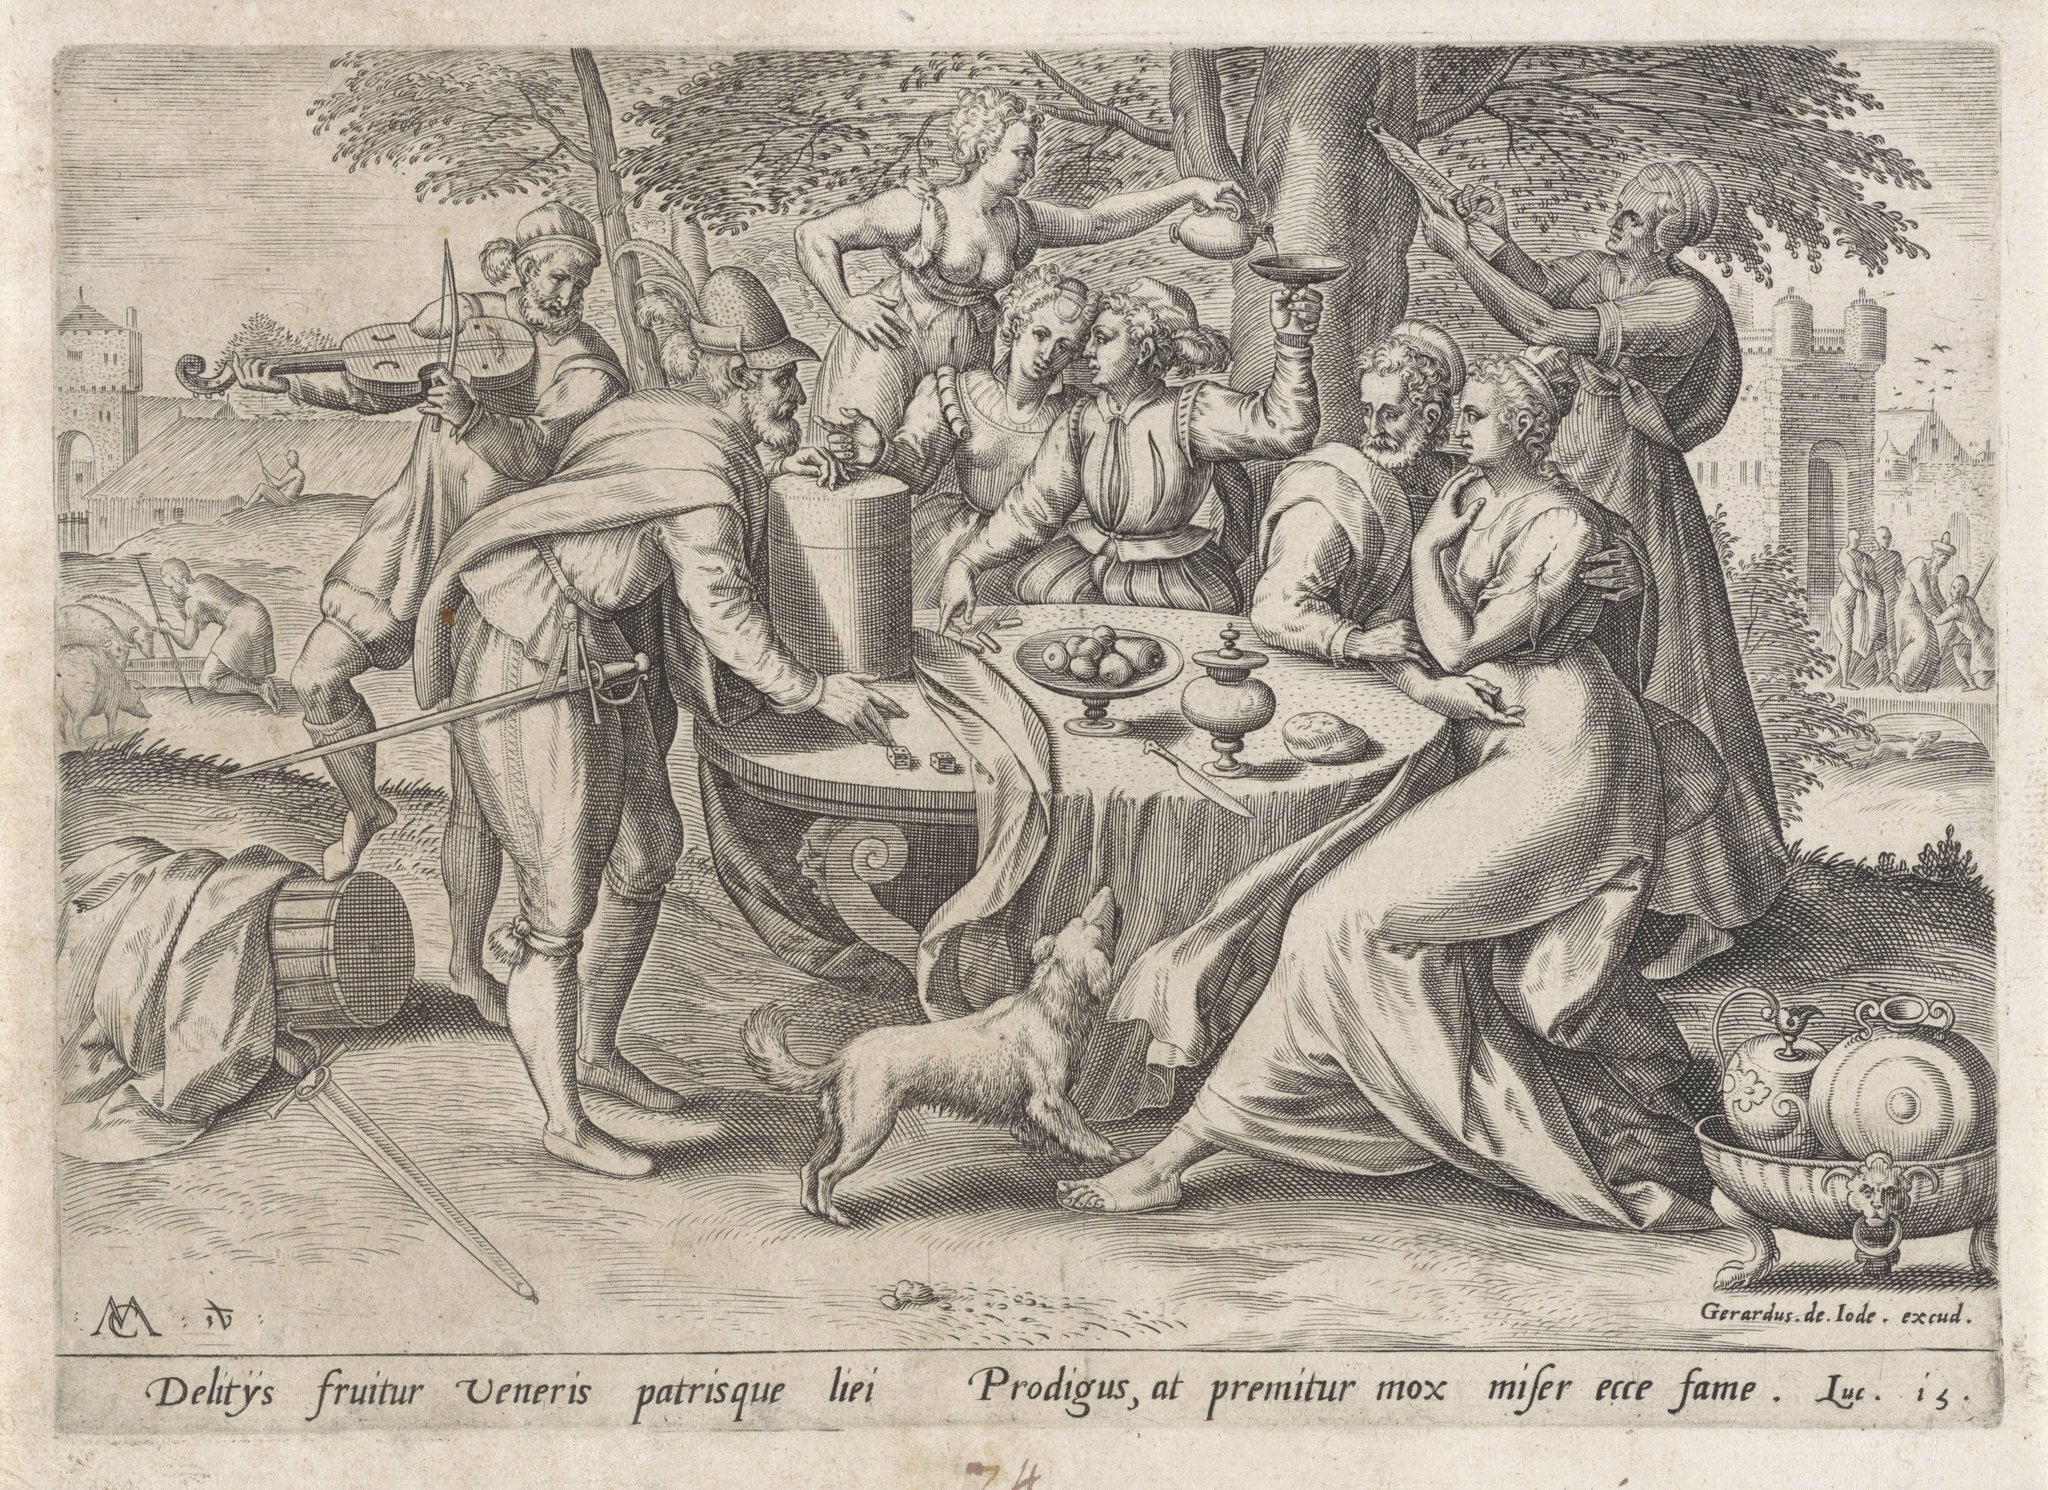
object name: print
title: Verloren zoon verkwist zijn geld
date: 1547-1591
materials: paper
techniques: engraving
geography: antwerp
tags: the prodigal son in the midst of prostitutes feasting and dissipating his patrimony, usually in a brothel or inn, the prodigal son returns home, where his father awaits him, the prodigal son tends the swine and eats from their trough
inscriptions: number: ‘74’, collector's mark: Lugt 2228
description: De verloren zoon zit temidden van prostituees en muzikanten een aan tafel in de buitenlucht. Een vrouw met ontblote borsten vult zijn drinkschaal bij. Op tafel liggen etenswaren en dobbelstenen. Linksachter eet hij met de varkens uit een trog en rechtsachter knielt hij voor zijn vader bij thuiskomst. In de marge een éénregelig onderschrift uit Luc. 15 in het Latijn.